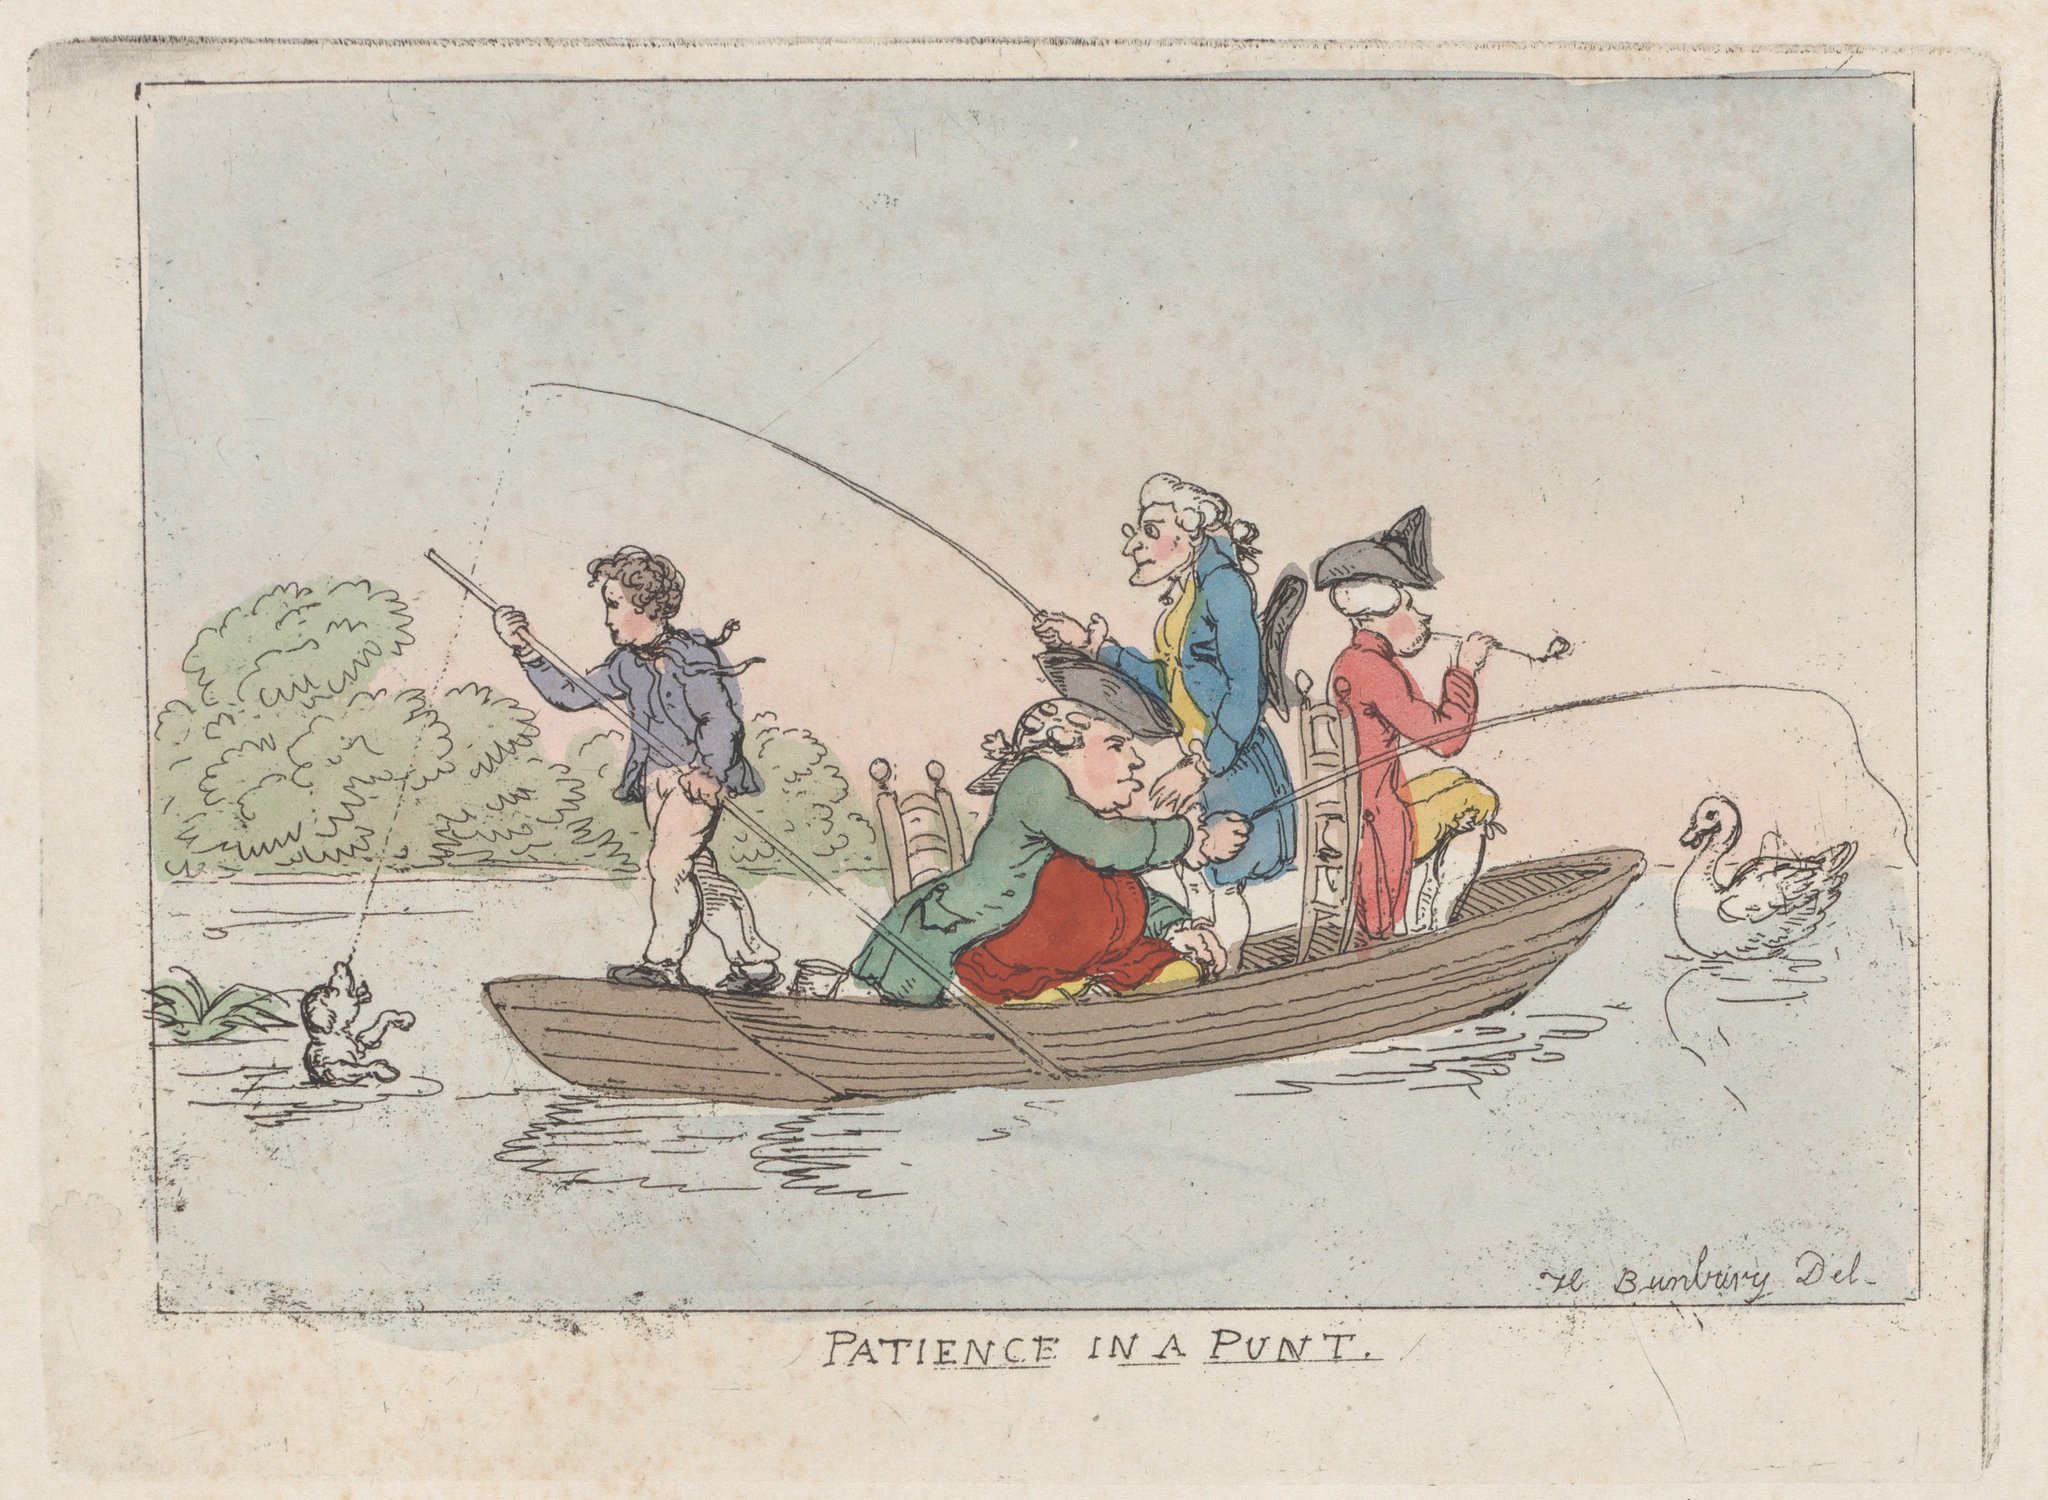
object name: print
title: Patience in a Punt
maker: thomas rowlandson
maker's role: artist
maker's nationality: british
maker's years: 1757-1827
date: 1803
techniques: etching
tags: satire,men,fishing,boats